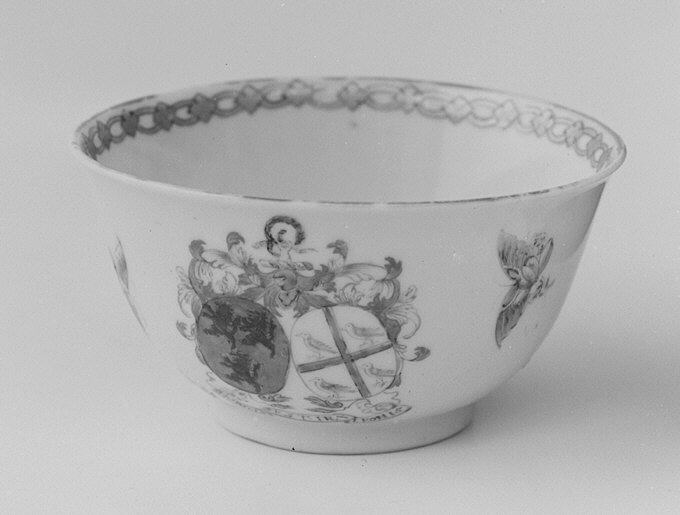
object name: teacup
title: Tea cup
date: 1760-1770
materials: hard paste porcelain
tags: coat of arms